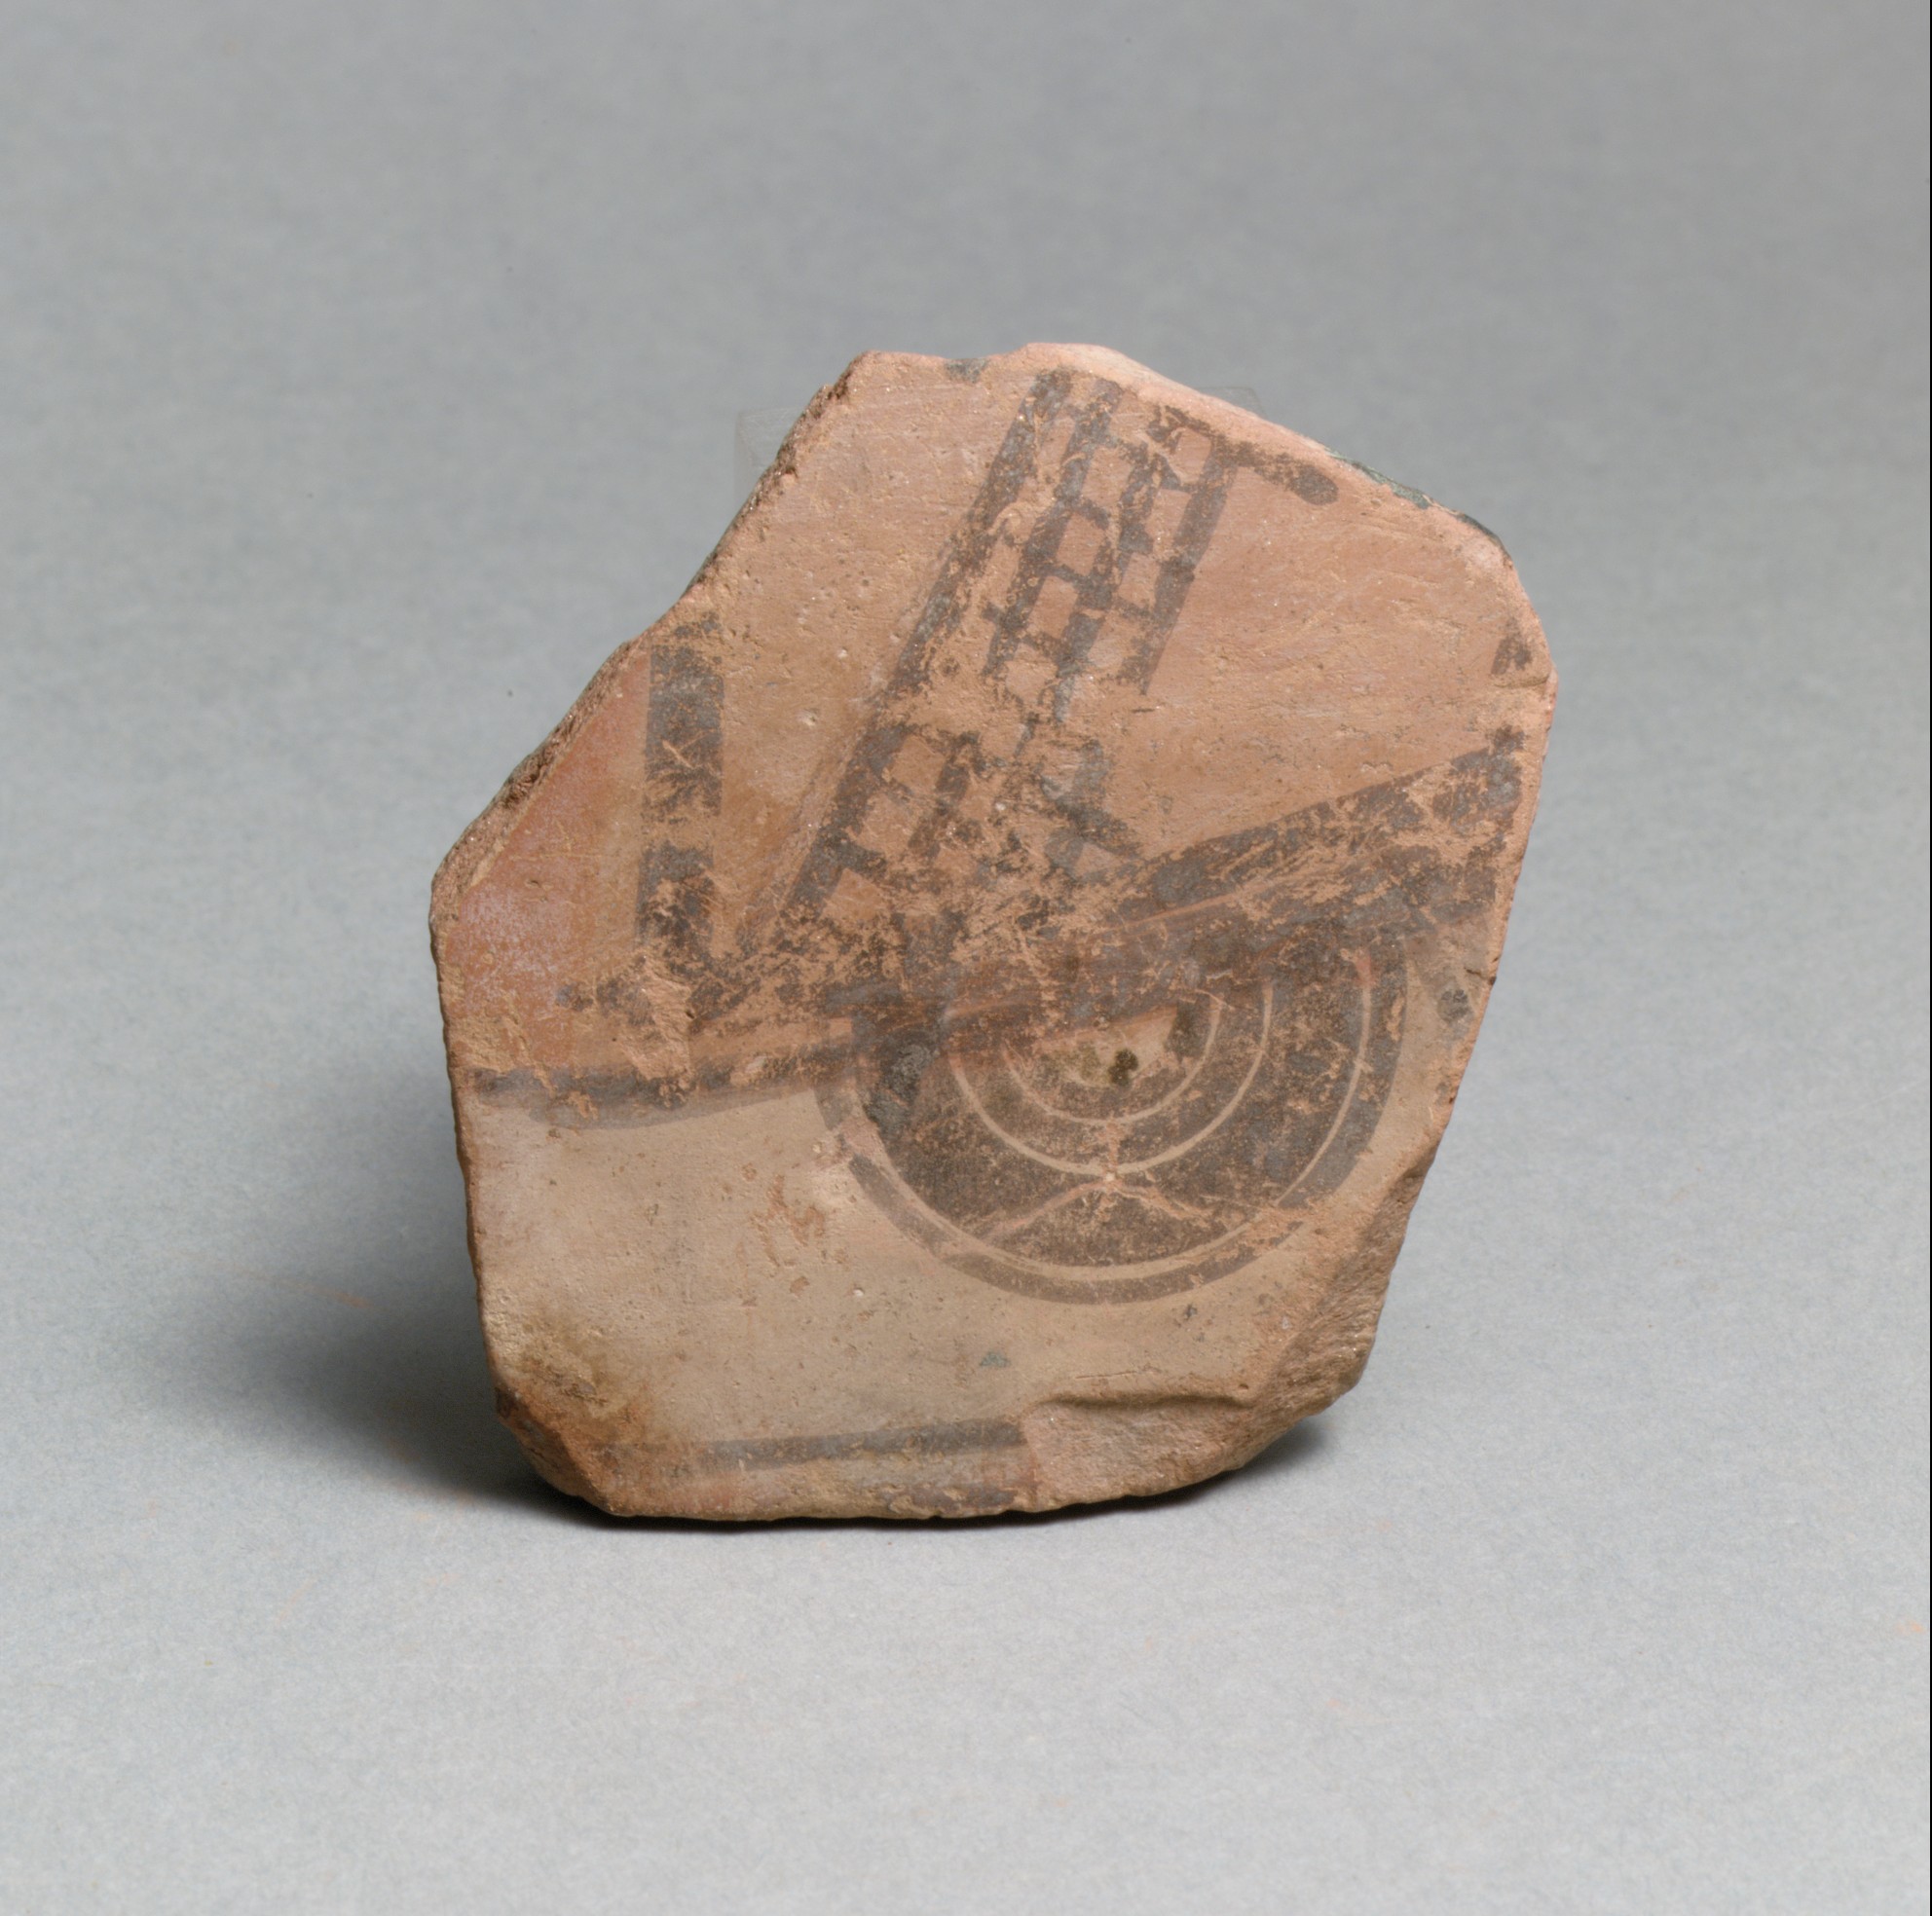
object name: vase fragment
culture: greek or lydian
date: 1050-700 BCE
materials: terracotta